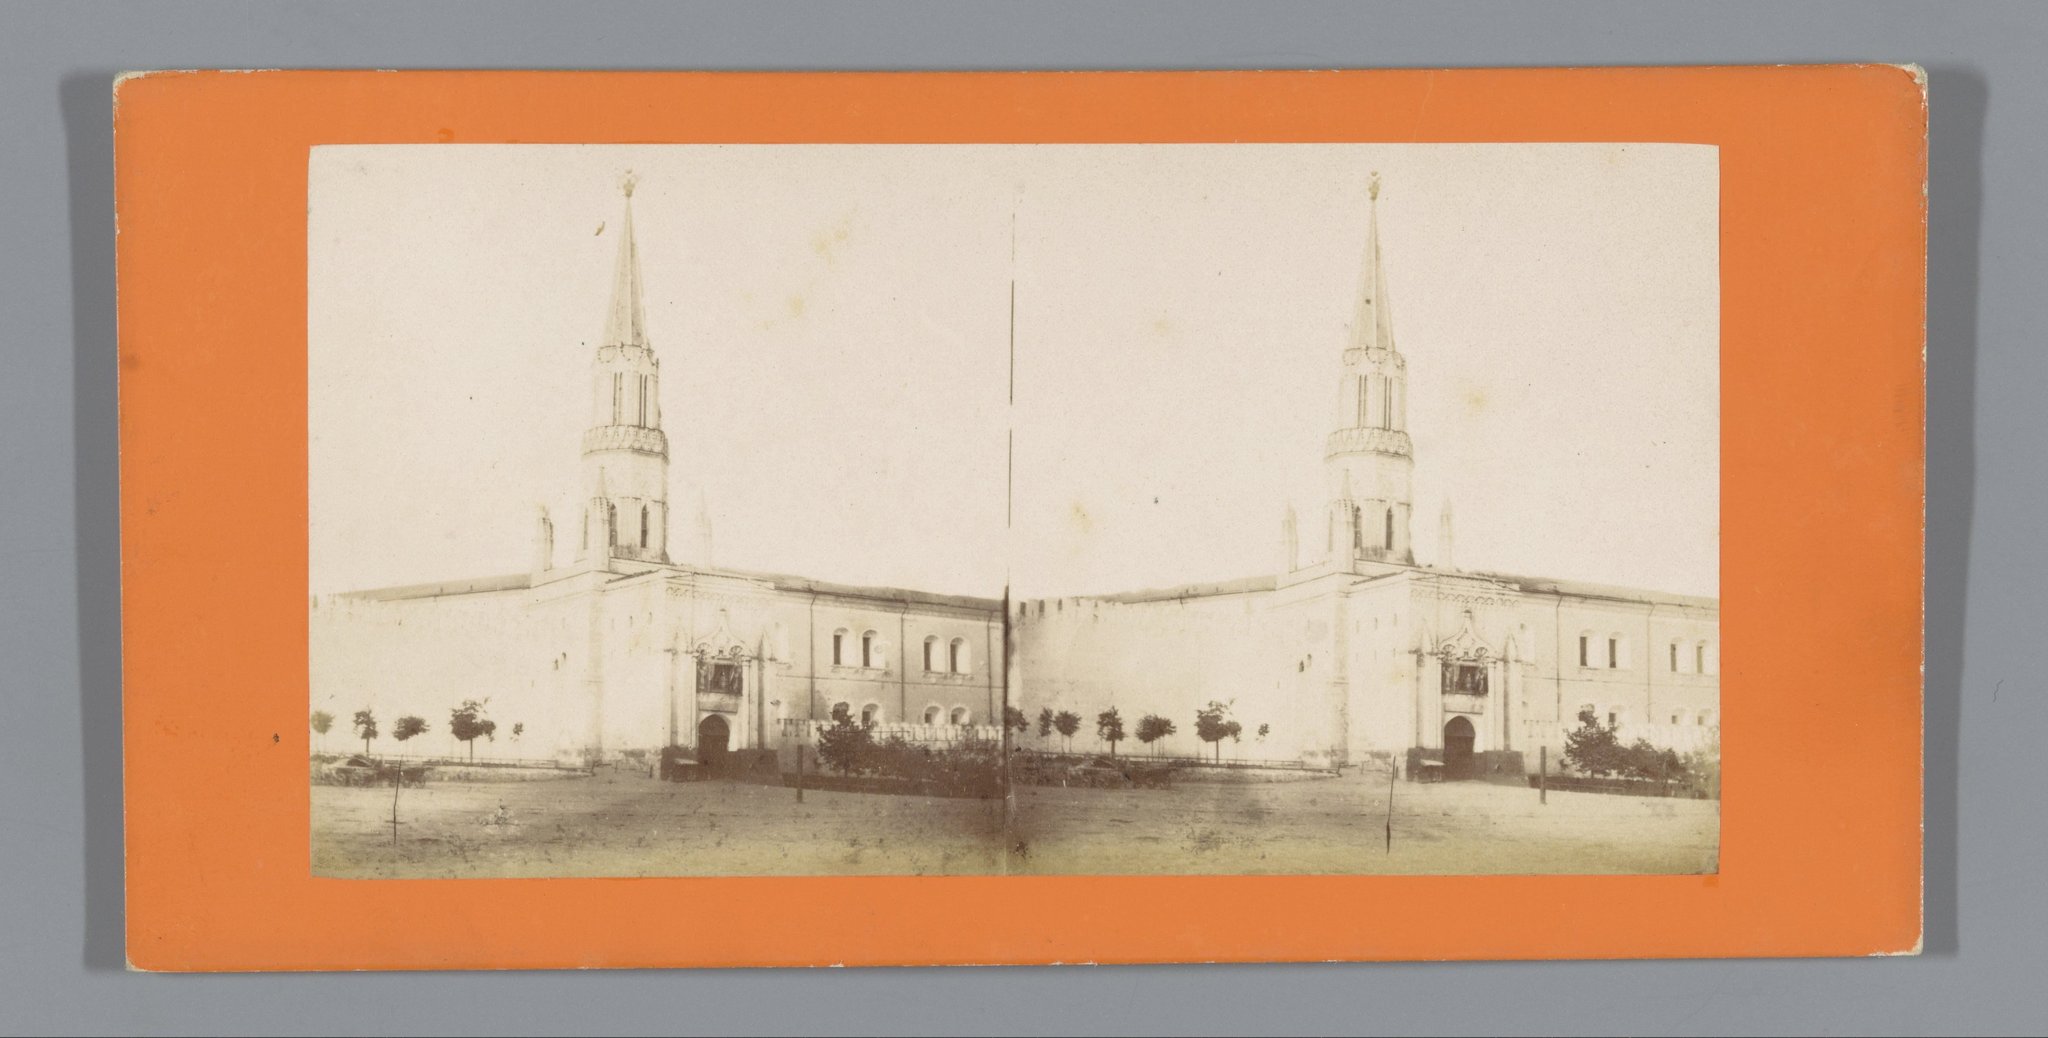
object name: stereograph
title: Gezicht op de Nikolskayatoren van het Kremlin in Moskou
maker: Anonymous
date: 1850-1880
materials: cardboard, photographic support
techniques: albumen print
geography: moscow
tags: tower, clock tower ~ monumental adornment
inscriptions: inscription: ‘98 Porte St Nicolas Moscou’